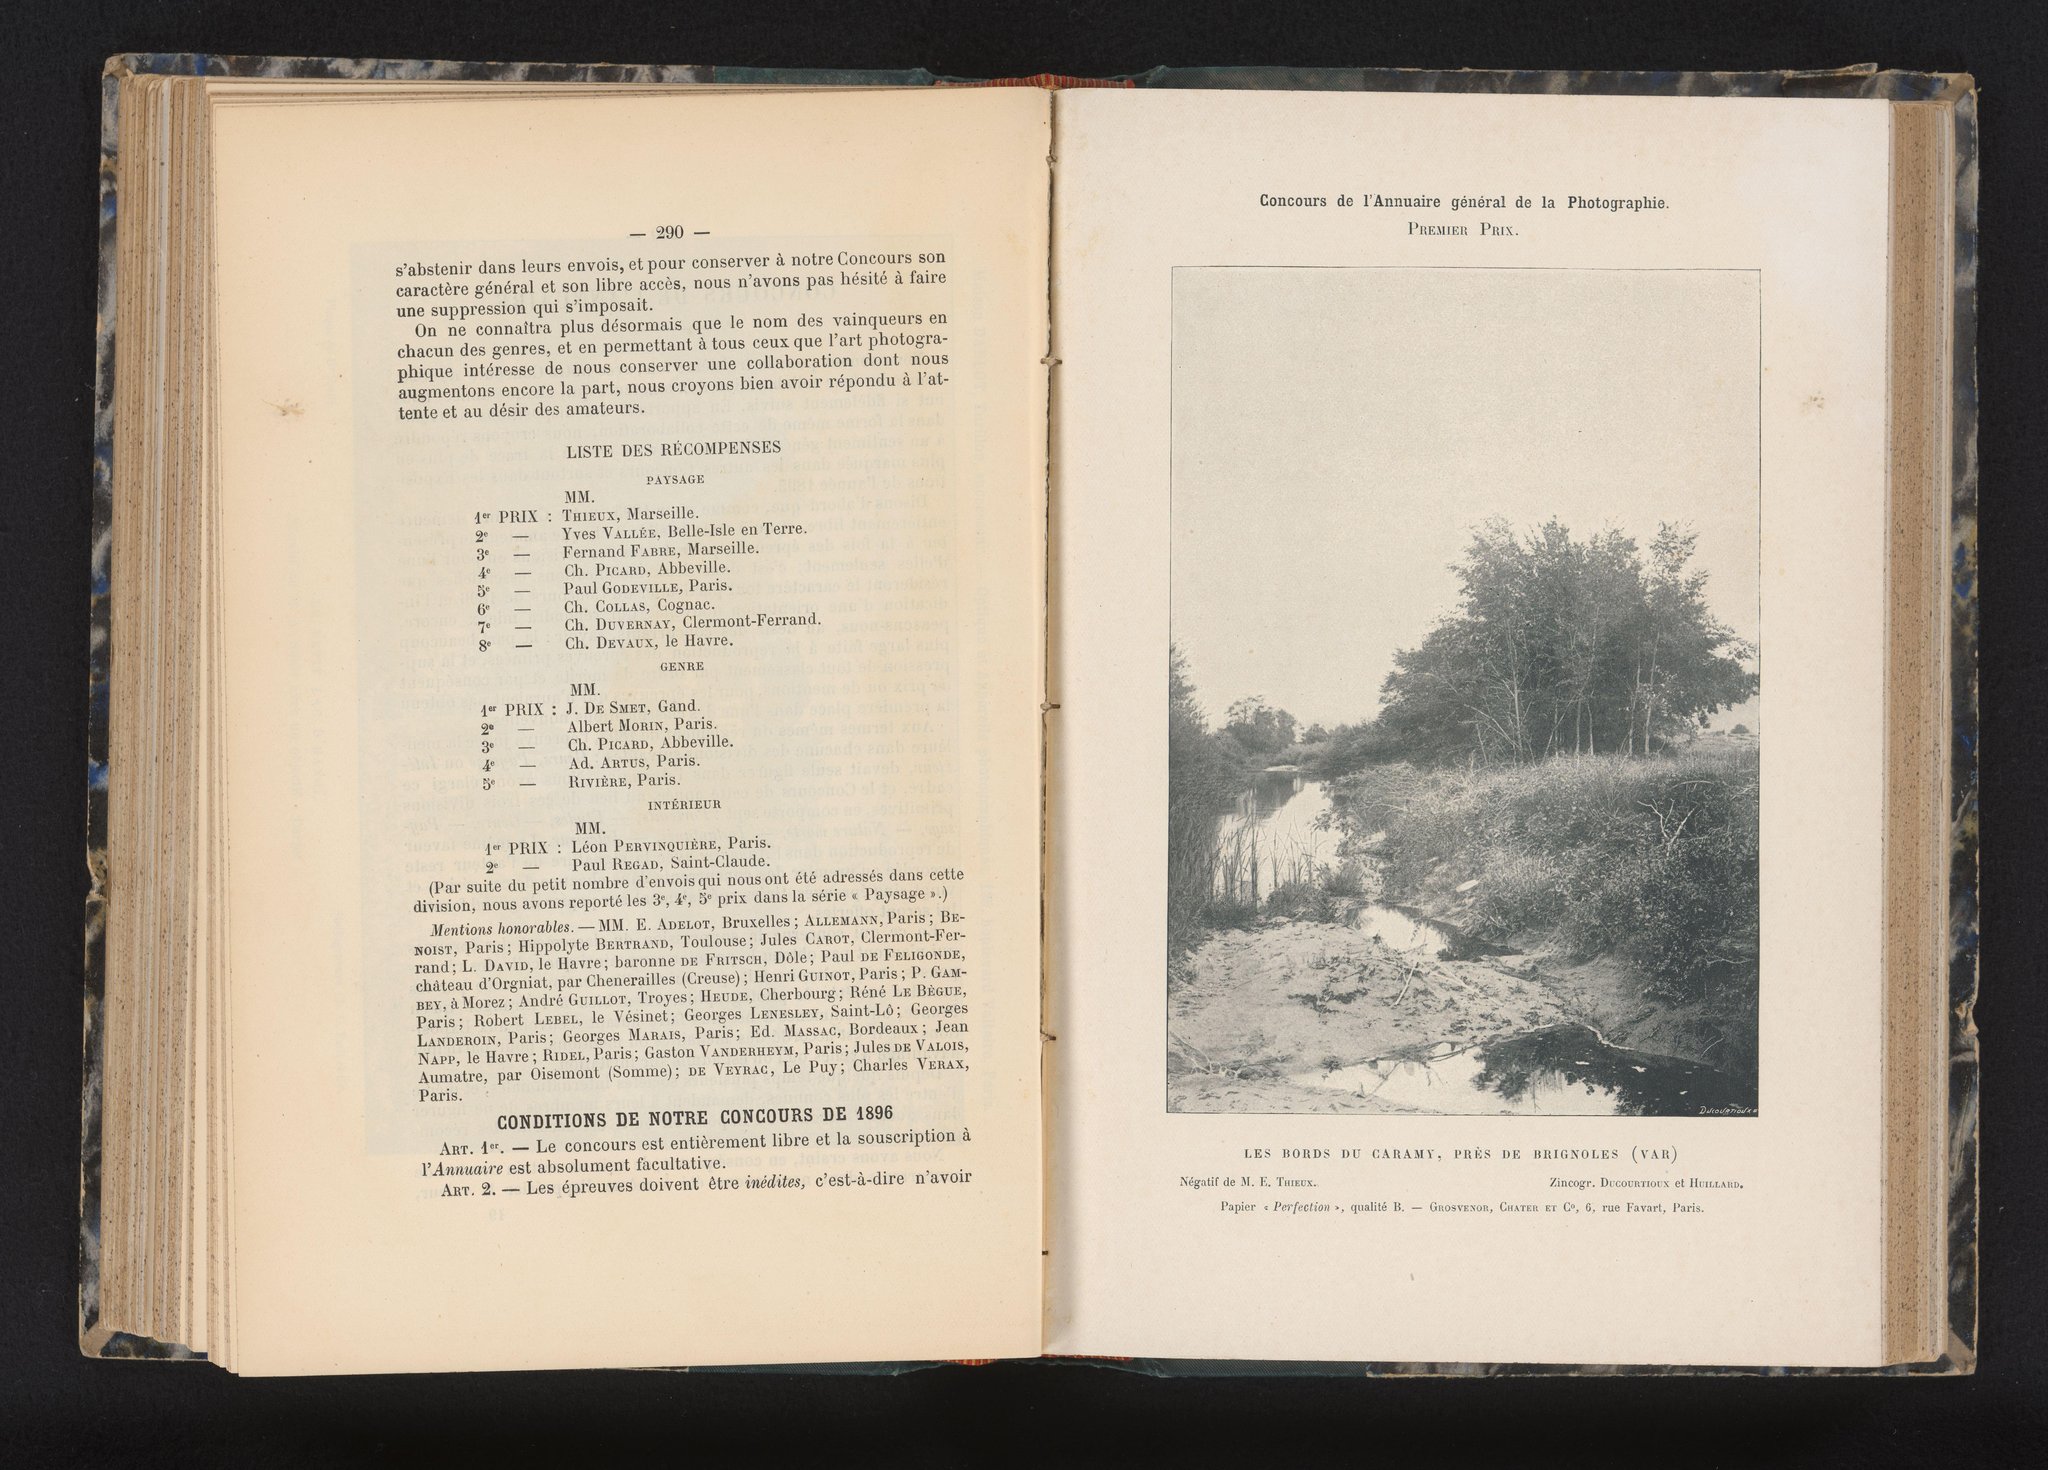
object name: photomechanical print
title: Les Bords du Caramy, près de Brignoles (Var)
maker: e. thieux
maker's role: fotograaf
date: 1891-1896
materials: paper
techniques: autotype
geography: brignoles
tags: river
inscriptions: inscription: ‘Papier < Perfection >, qualité B. - Grosvenor, Chater et Co, 6, rue Favart, Paris.’, inscription: ‘Concours de l'Annuaire général de la Photographie./ Premier Prix.’